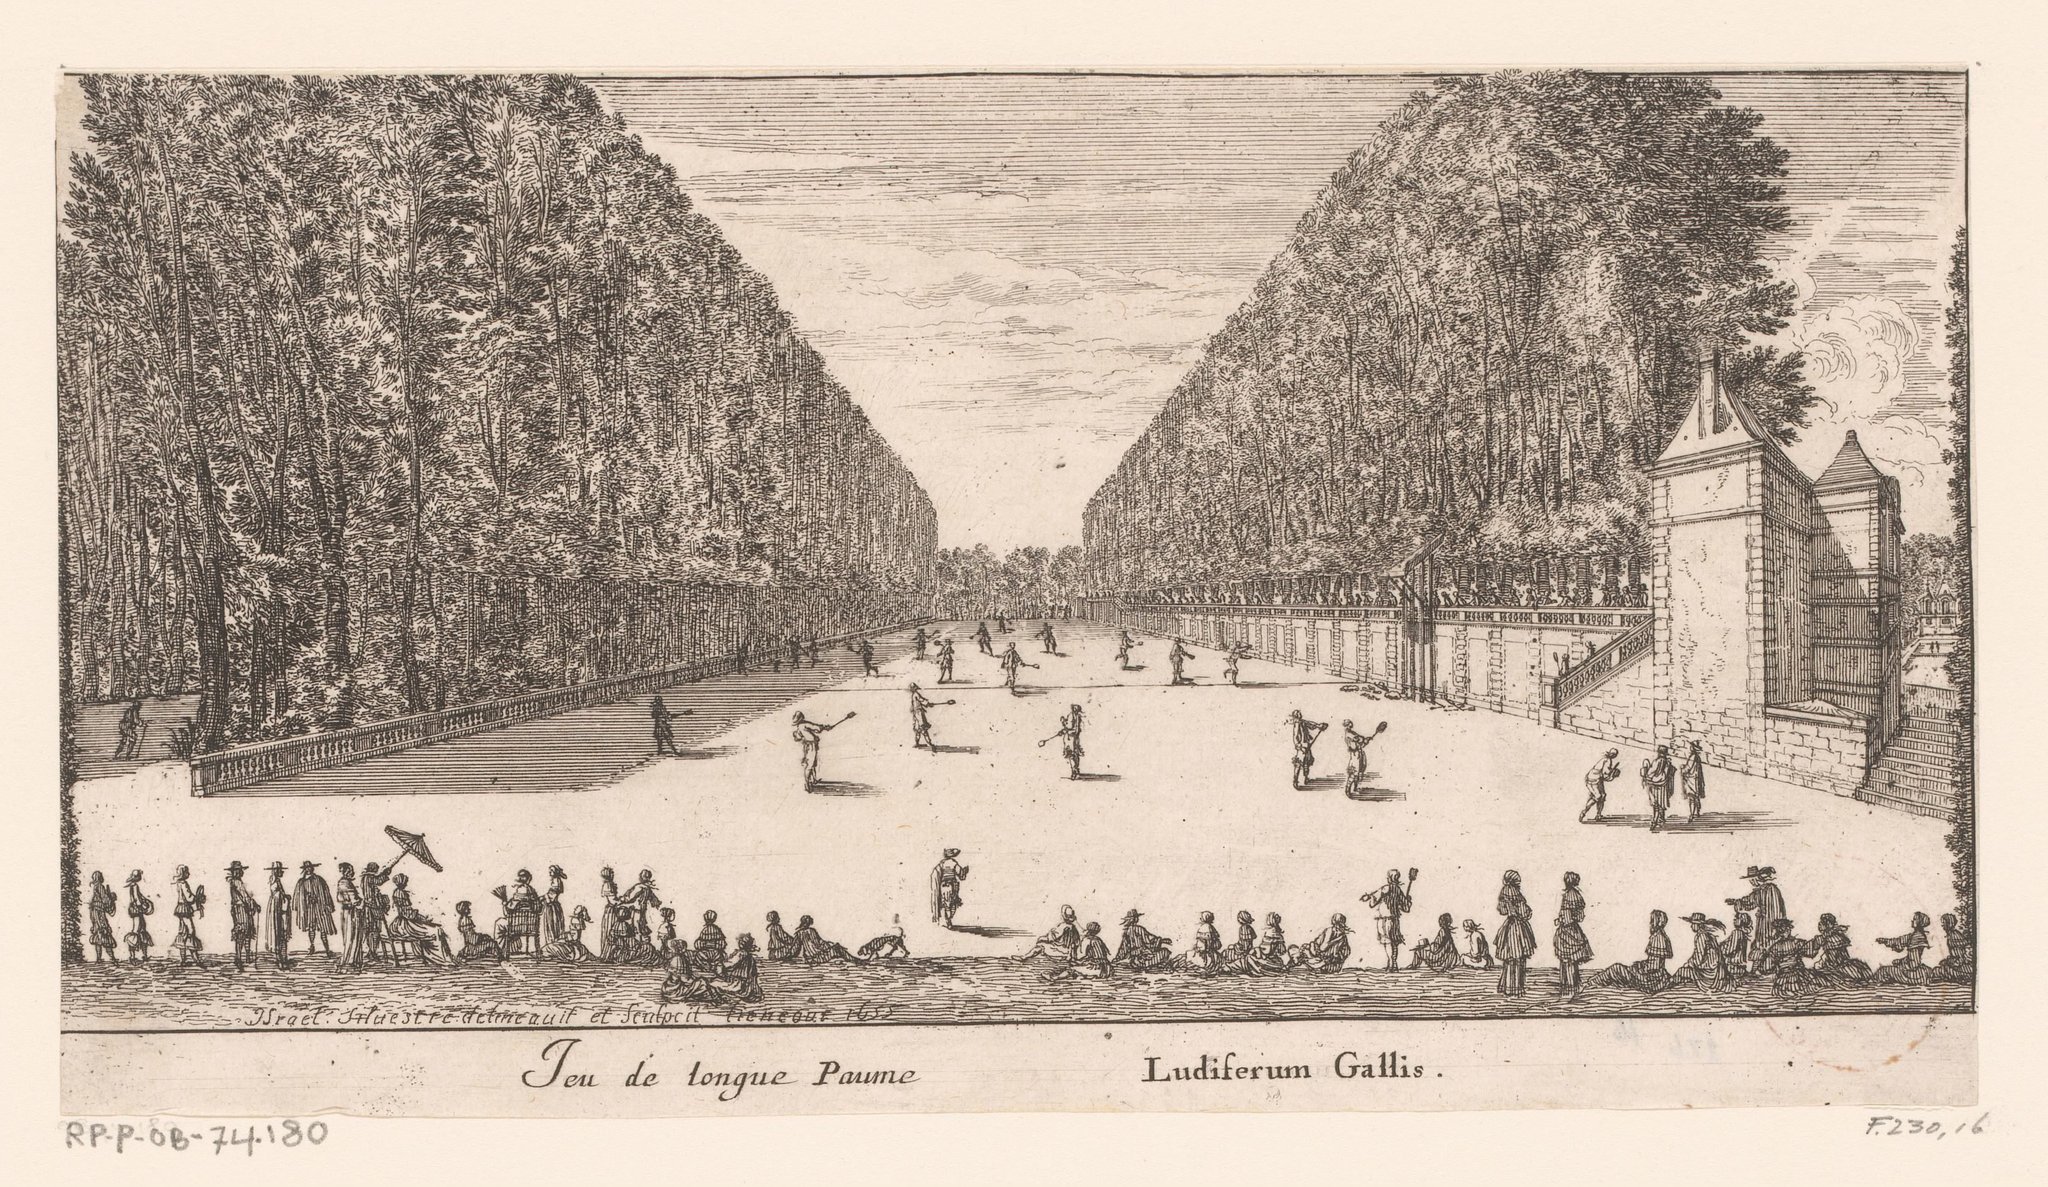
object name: print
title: Jeu de longue Paume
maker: israël silvestre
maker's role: draughtsman, print maker, publisher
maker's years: 1621-1691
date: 1656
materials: paper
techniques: engraving, etching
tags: tennis, lawn-tennis, landscape with tower or castle, paris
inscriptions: collector's mark: Lugt 240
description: Prent maakt deel uit van een ongenummerde serie van twaalf prenten.